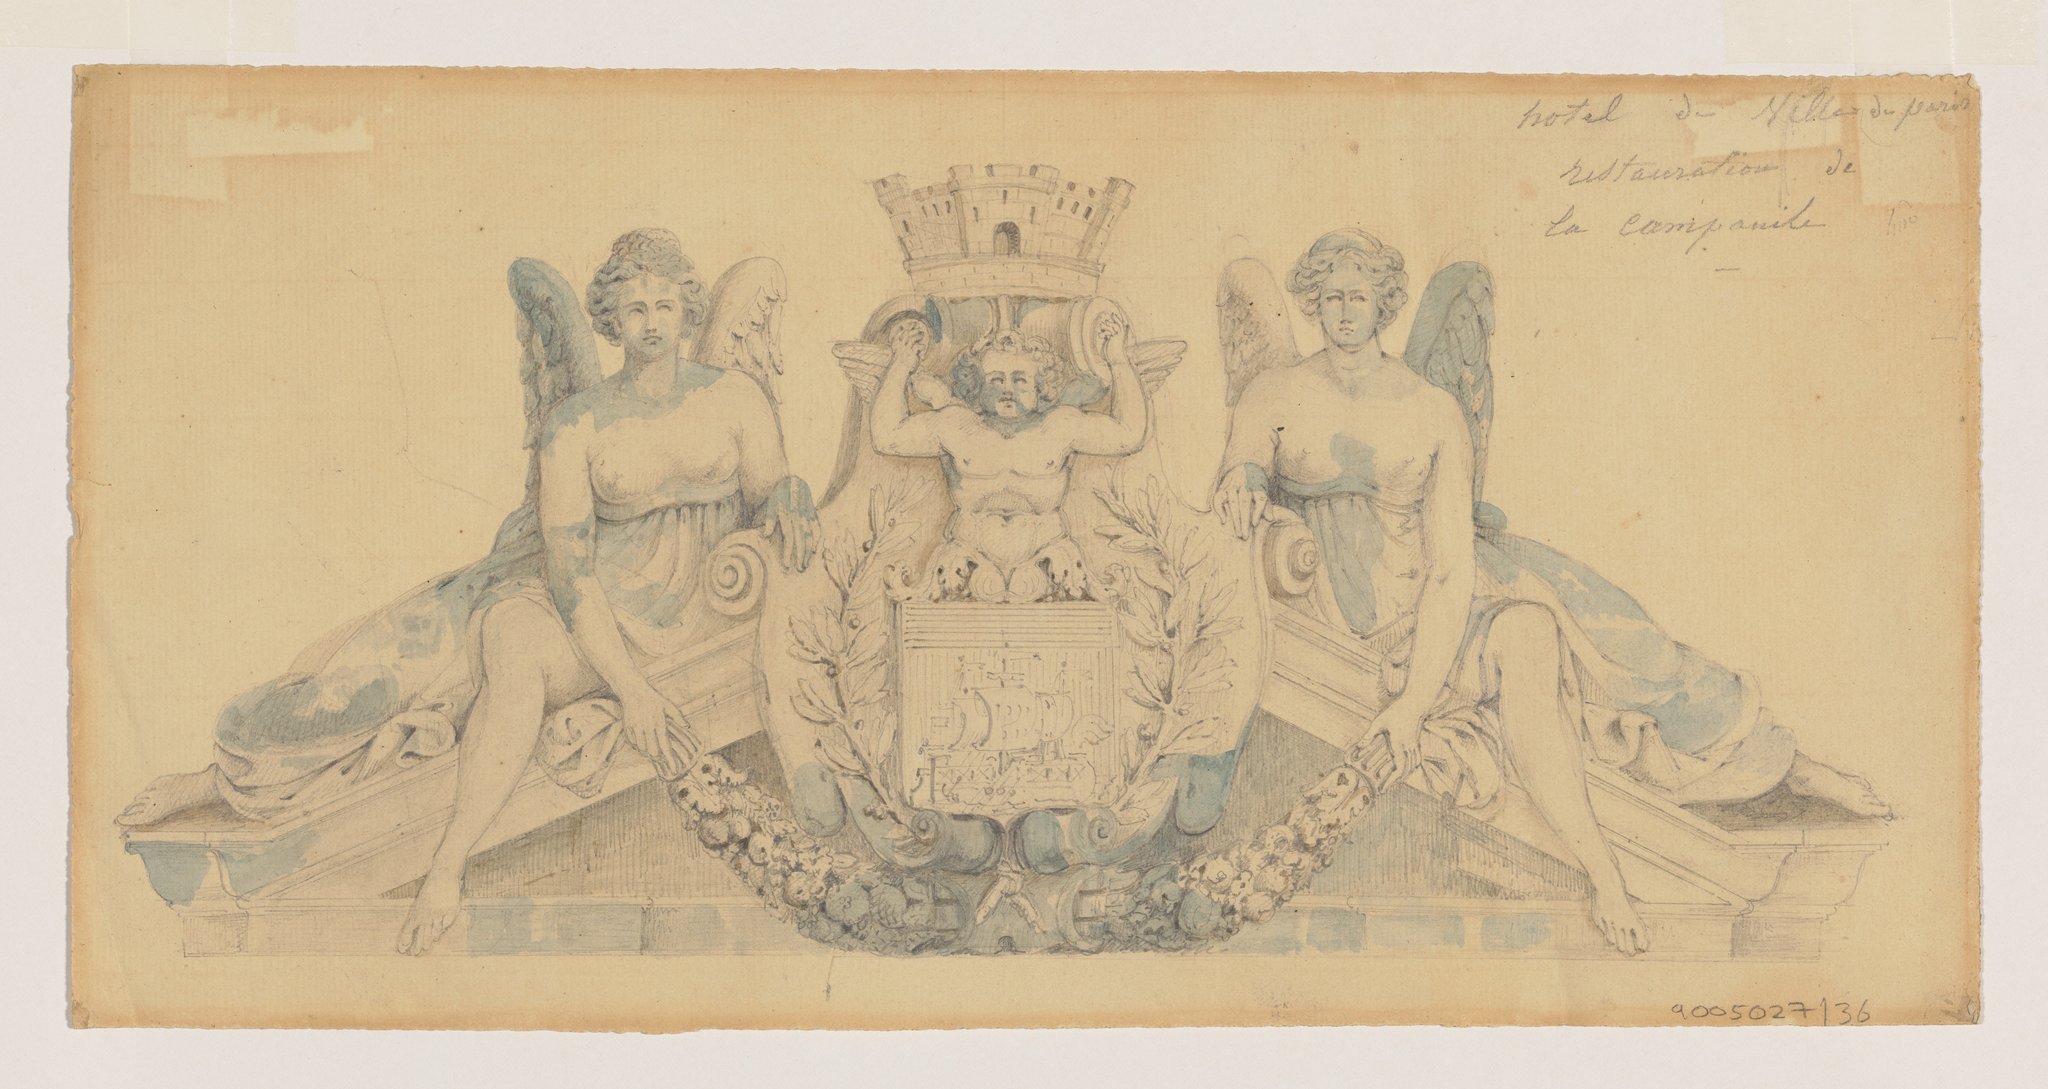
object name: drawing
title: Design for a Pediment (for the Hôtel de Ville)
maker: jean-baptiste louis plantar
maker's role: artist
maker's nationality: french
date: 1834-1866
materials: graphite, ink, watercolor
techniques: pen